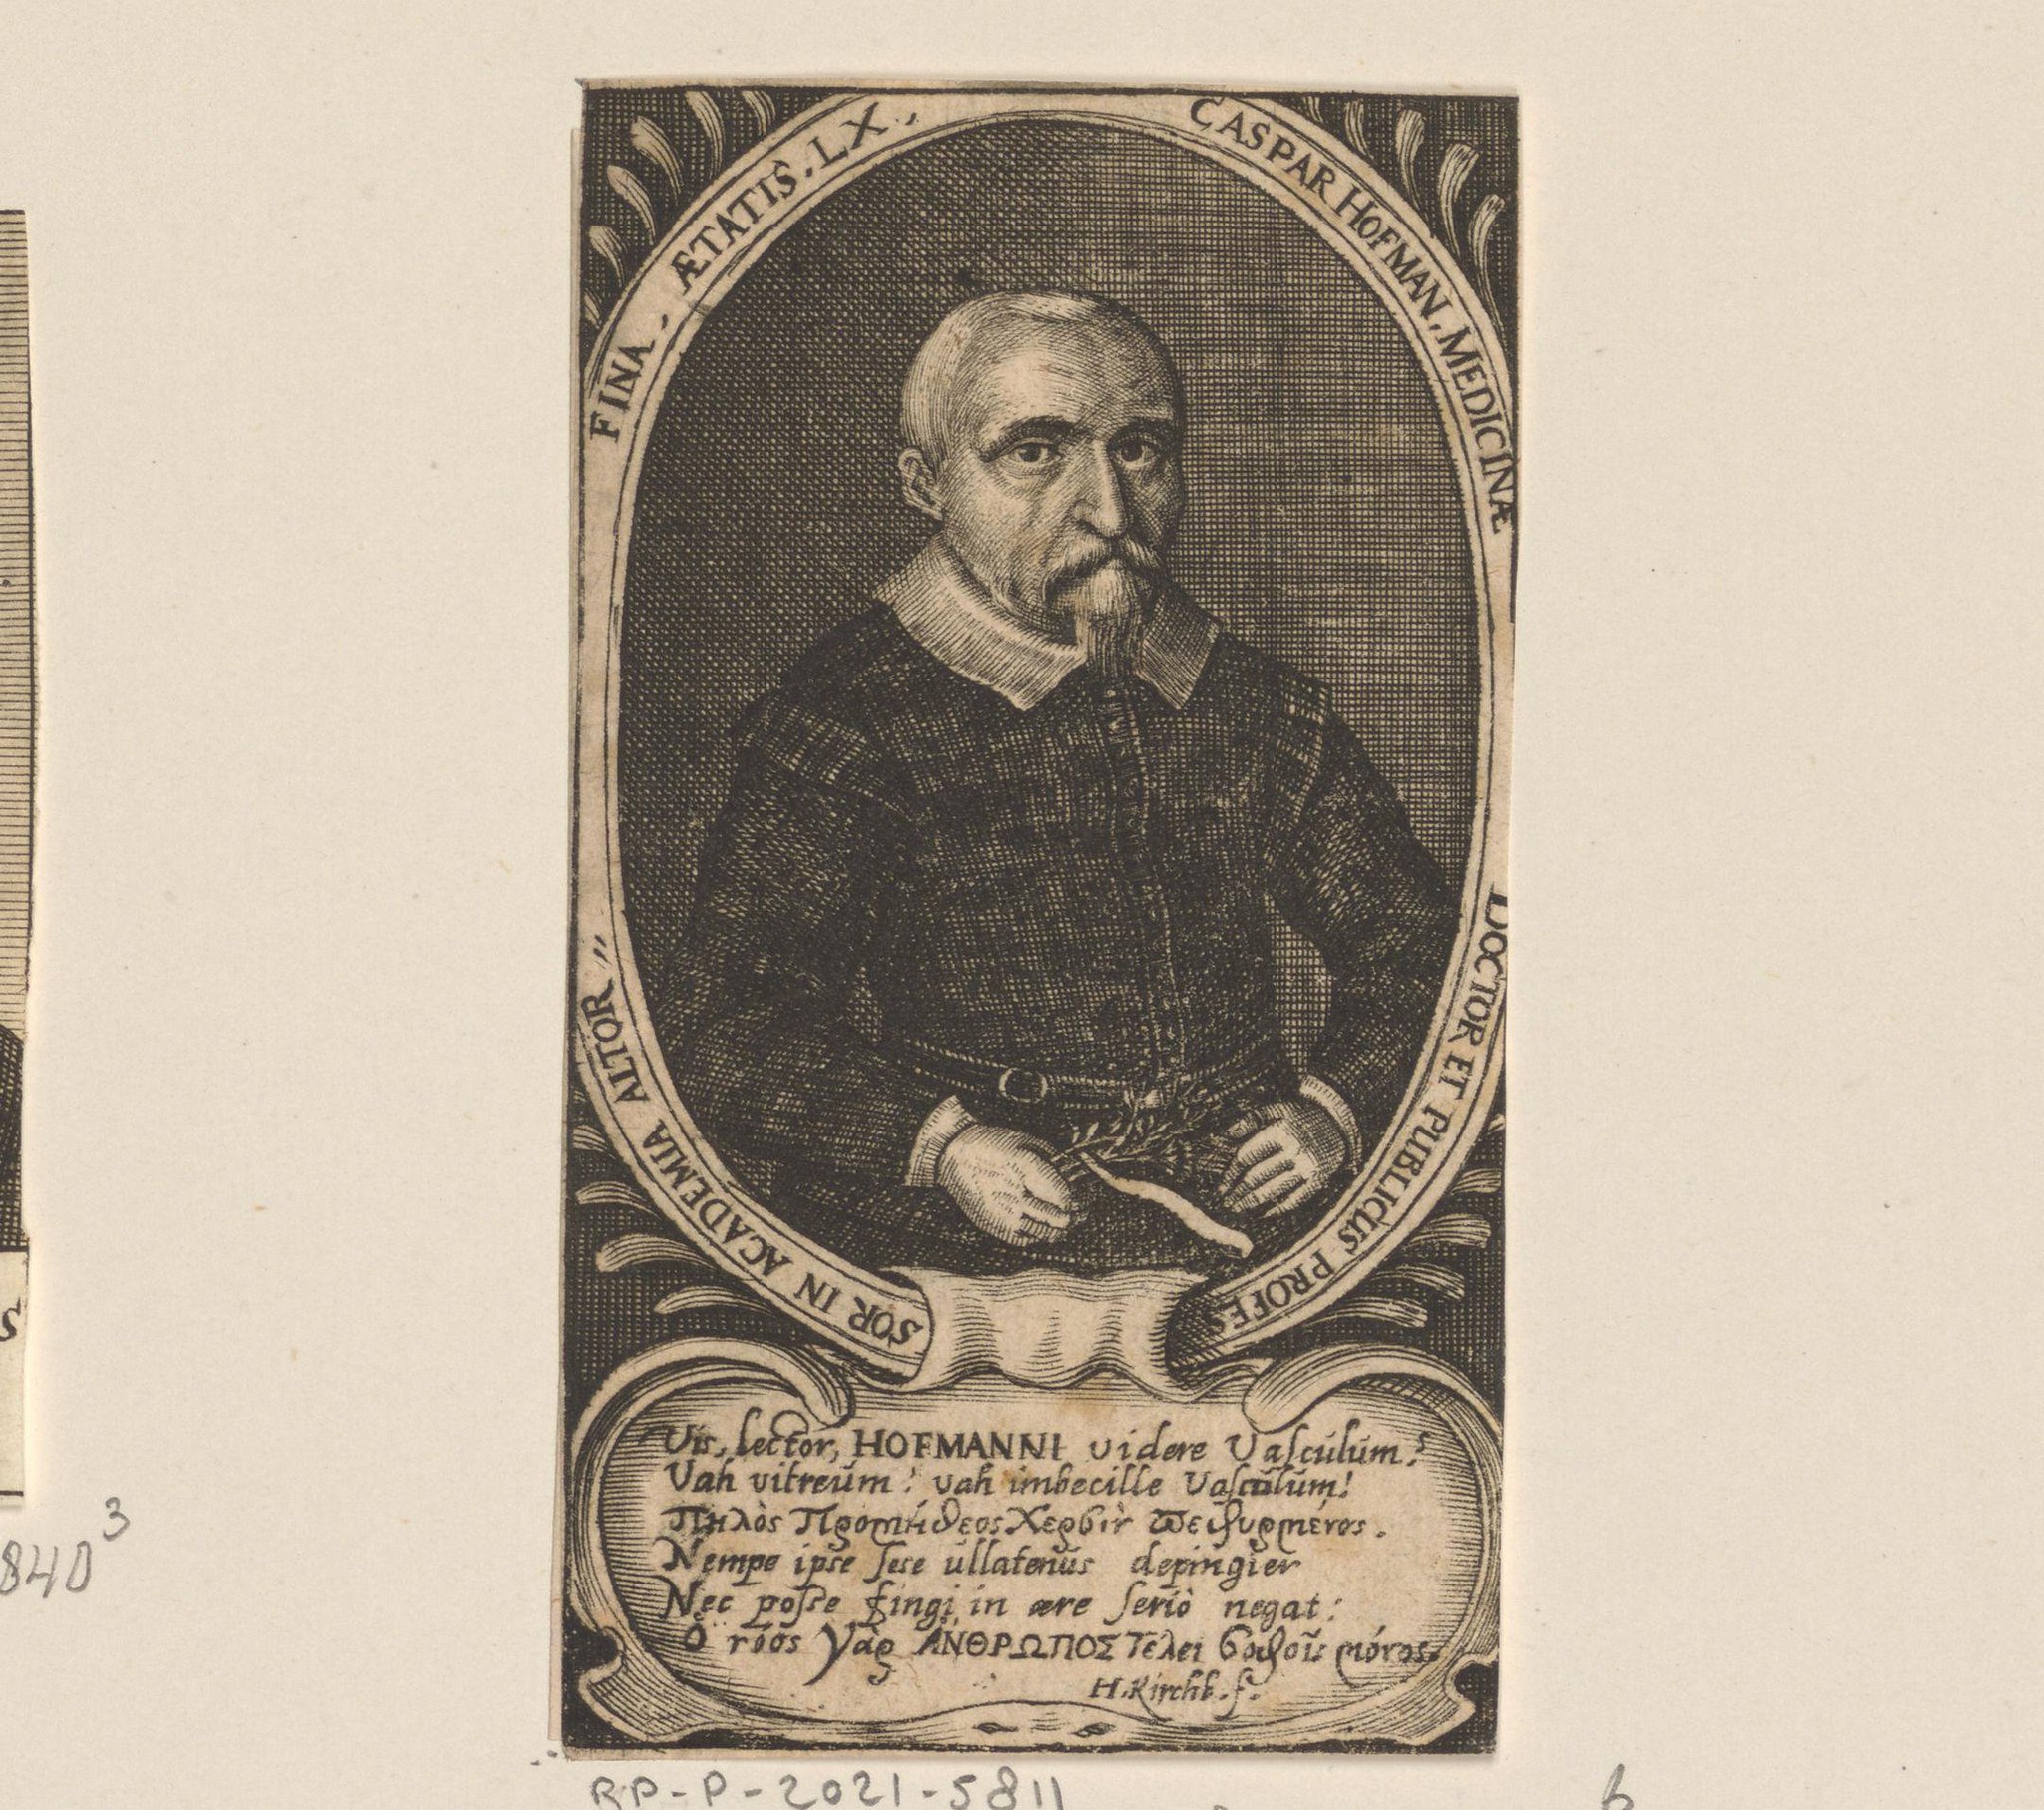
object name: print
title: Portret van Caspar Hoffmann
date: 1632-1670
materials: paper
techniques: engraving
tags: historical persons, physician, doctor